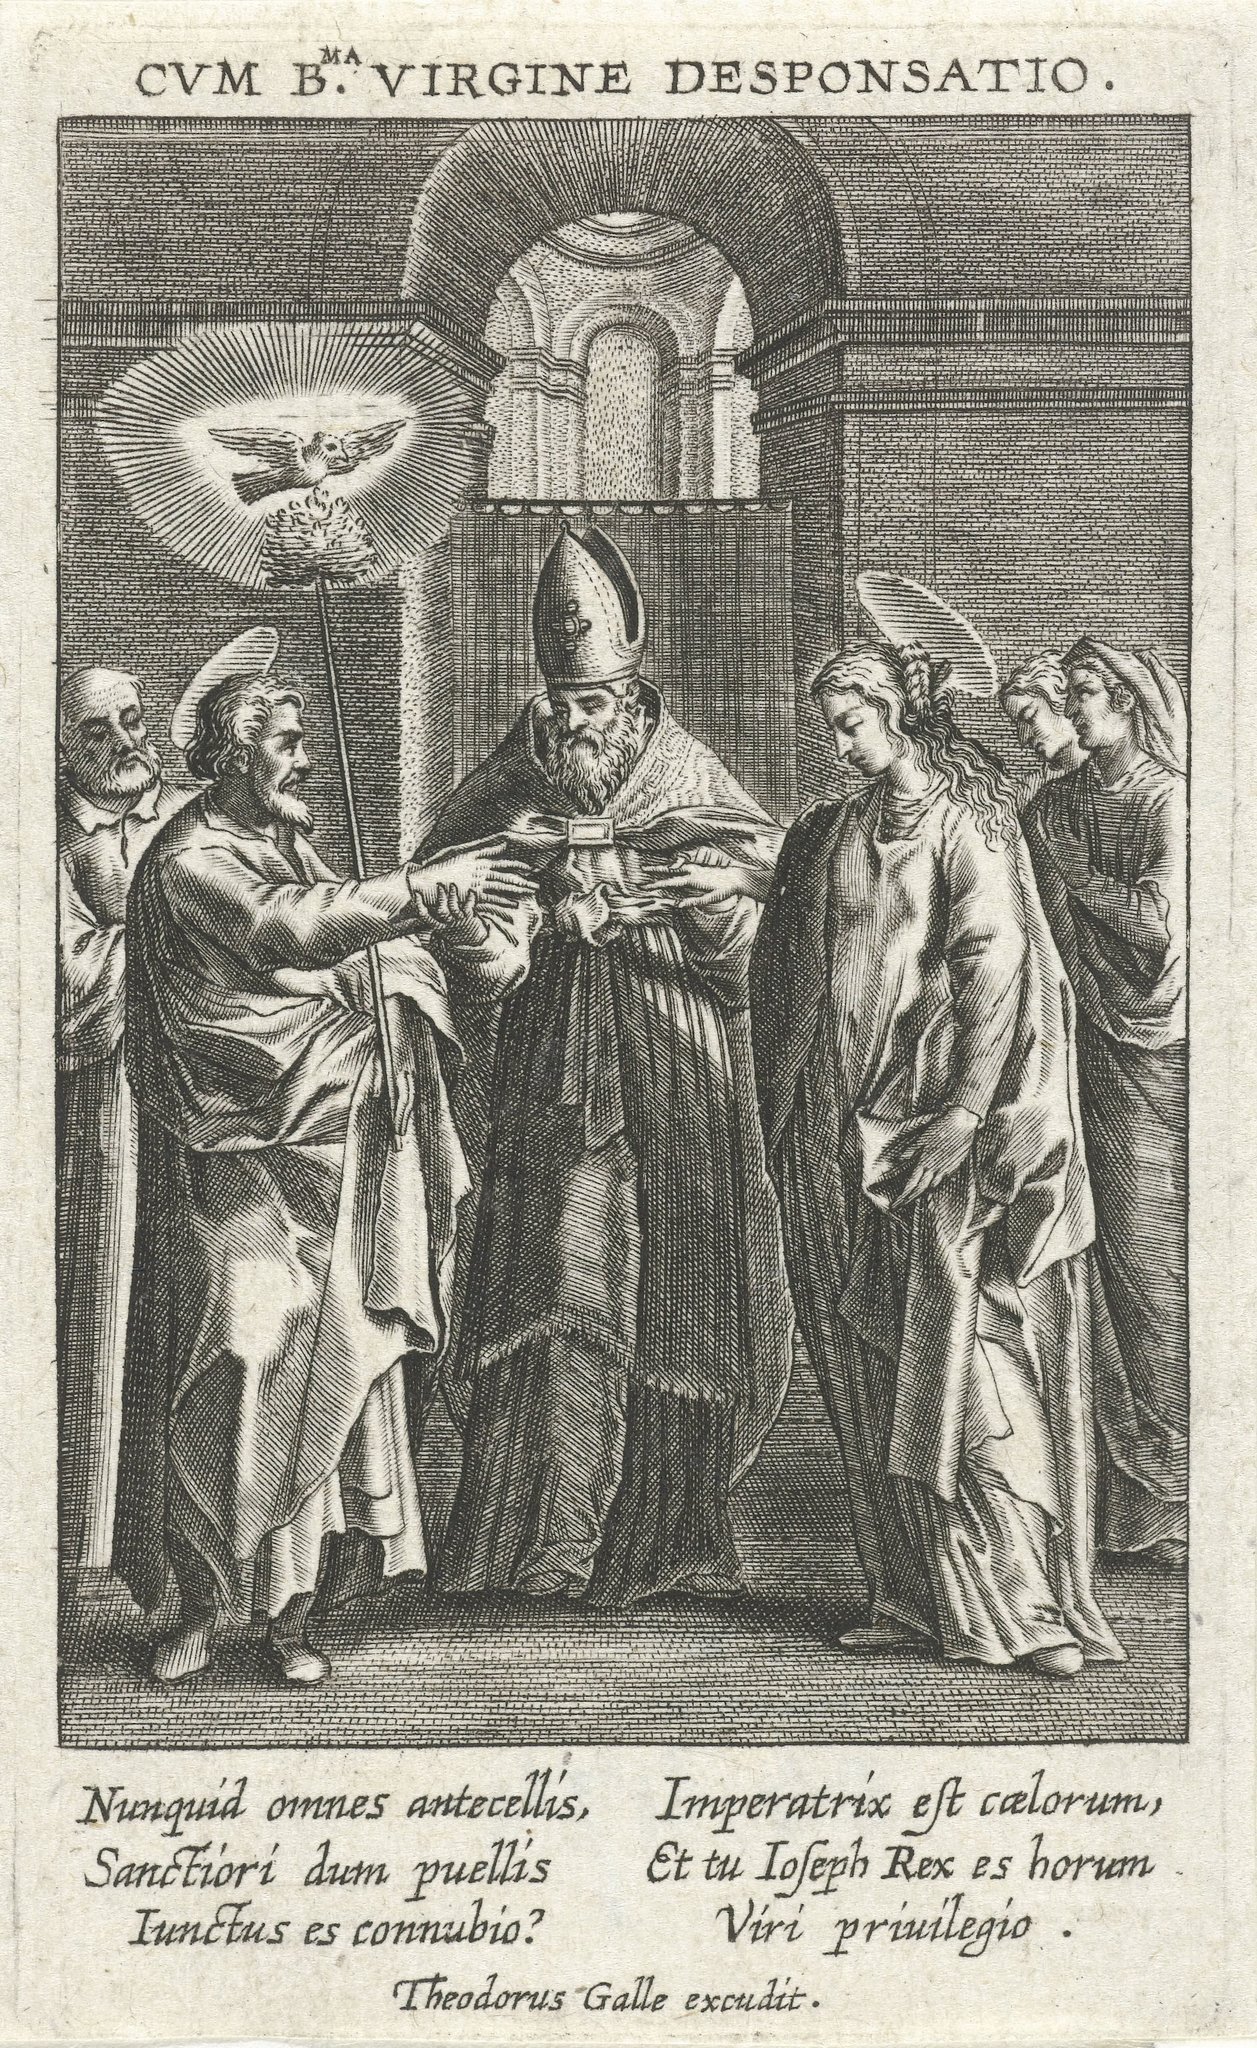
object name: print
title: Cvm B. Virgine Desponsatio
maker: theodoor galle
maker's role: print maker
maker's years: 1571-1633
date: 1581-1633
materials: paper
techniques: engraving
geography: antwerp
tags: recruitment of the bridegroom: the suitors are kneeling before the altar on which rods are placed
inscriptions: collector's mark: Lugt 2228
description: Maria moet een keuze maken uit verschillende huwelijkskandidaten. Jozefs stok bloeit en dit wordt gezien als een teken van God. Uit de stok komt een duif (de Heilige Geest) tevoorschijn. De prent heeft een Latijns onderschrift en maakt deel uit van een zestiendelige serie met taferelen uit het leven van de Heilige Familie.